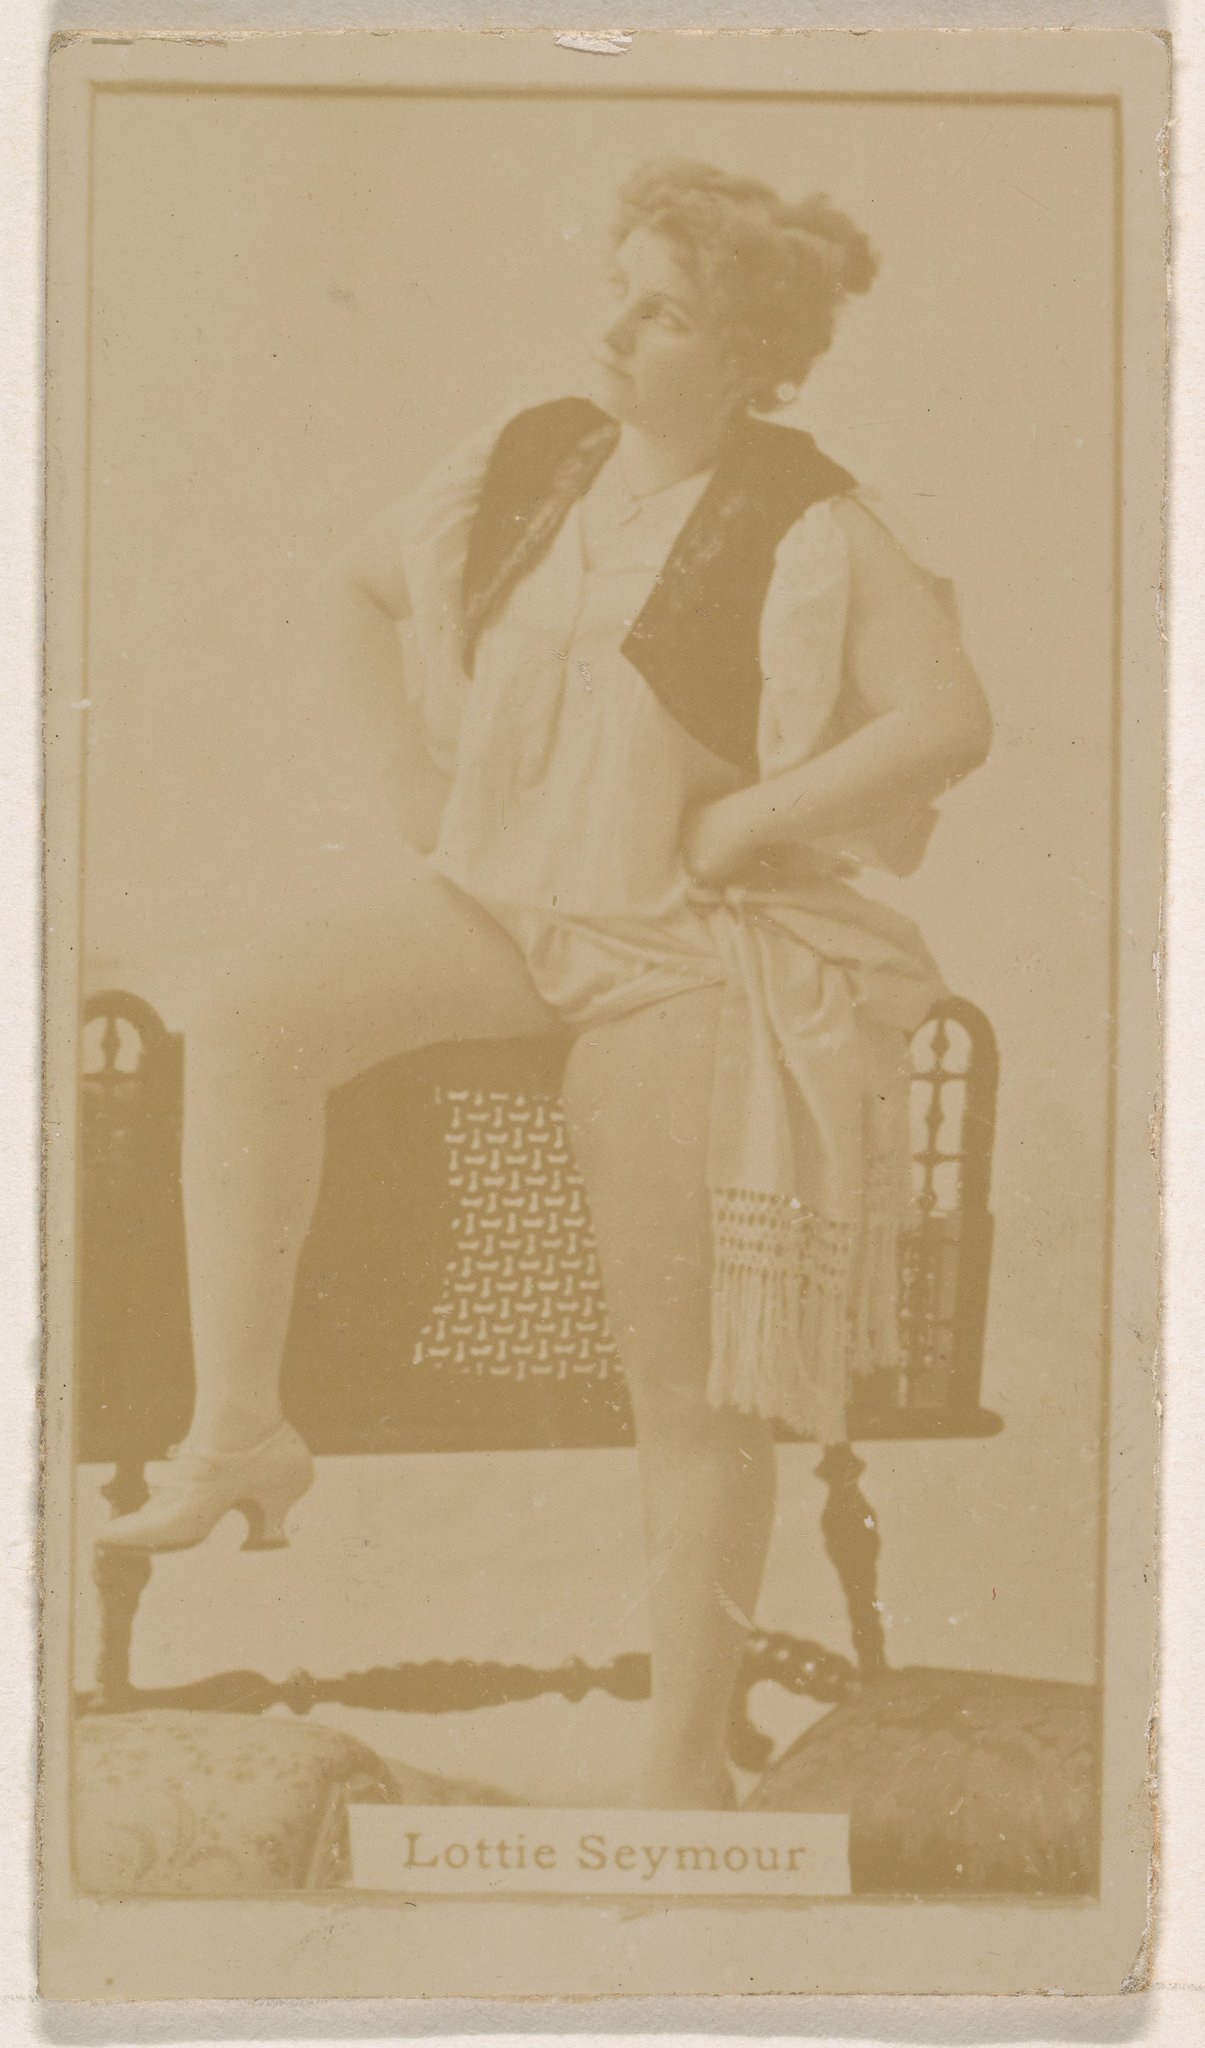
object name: photograph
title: Lottie Seymour, from the Actresses series (N245) issued by Kinney Brothers to promote Sweet Caporal Cigarettes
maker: kinney brothers tobacco company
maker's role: publisher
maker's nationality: american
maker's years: 1869-2011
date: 1890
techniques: albumen silver print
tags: portraits,women,actresses